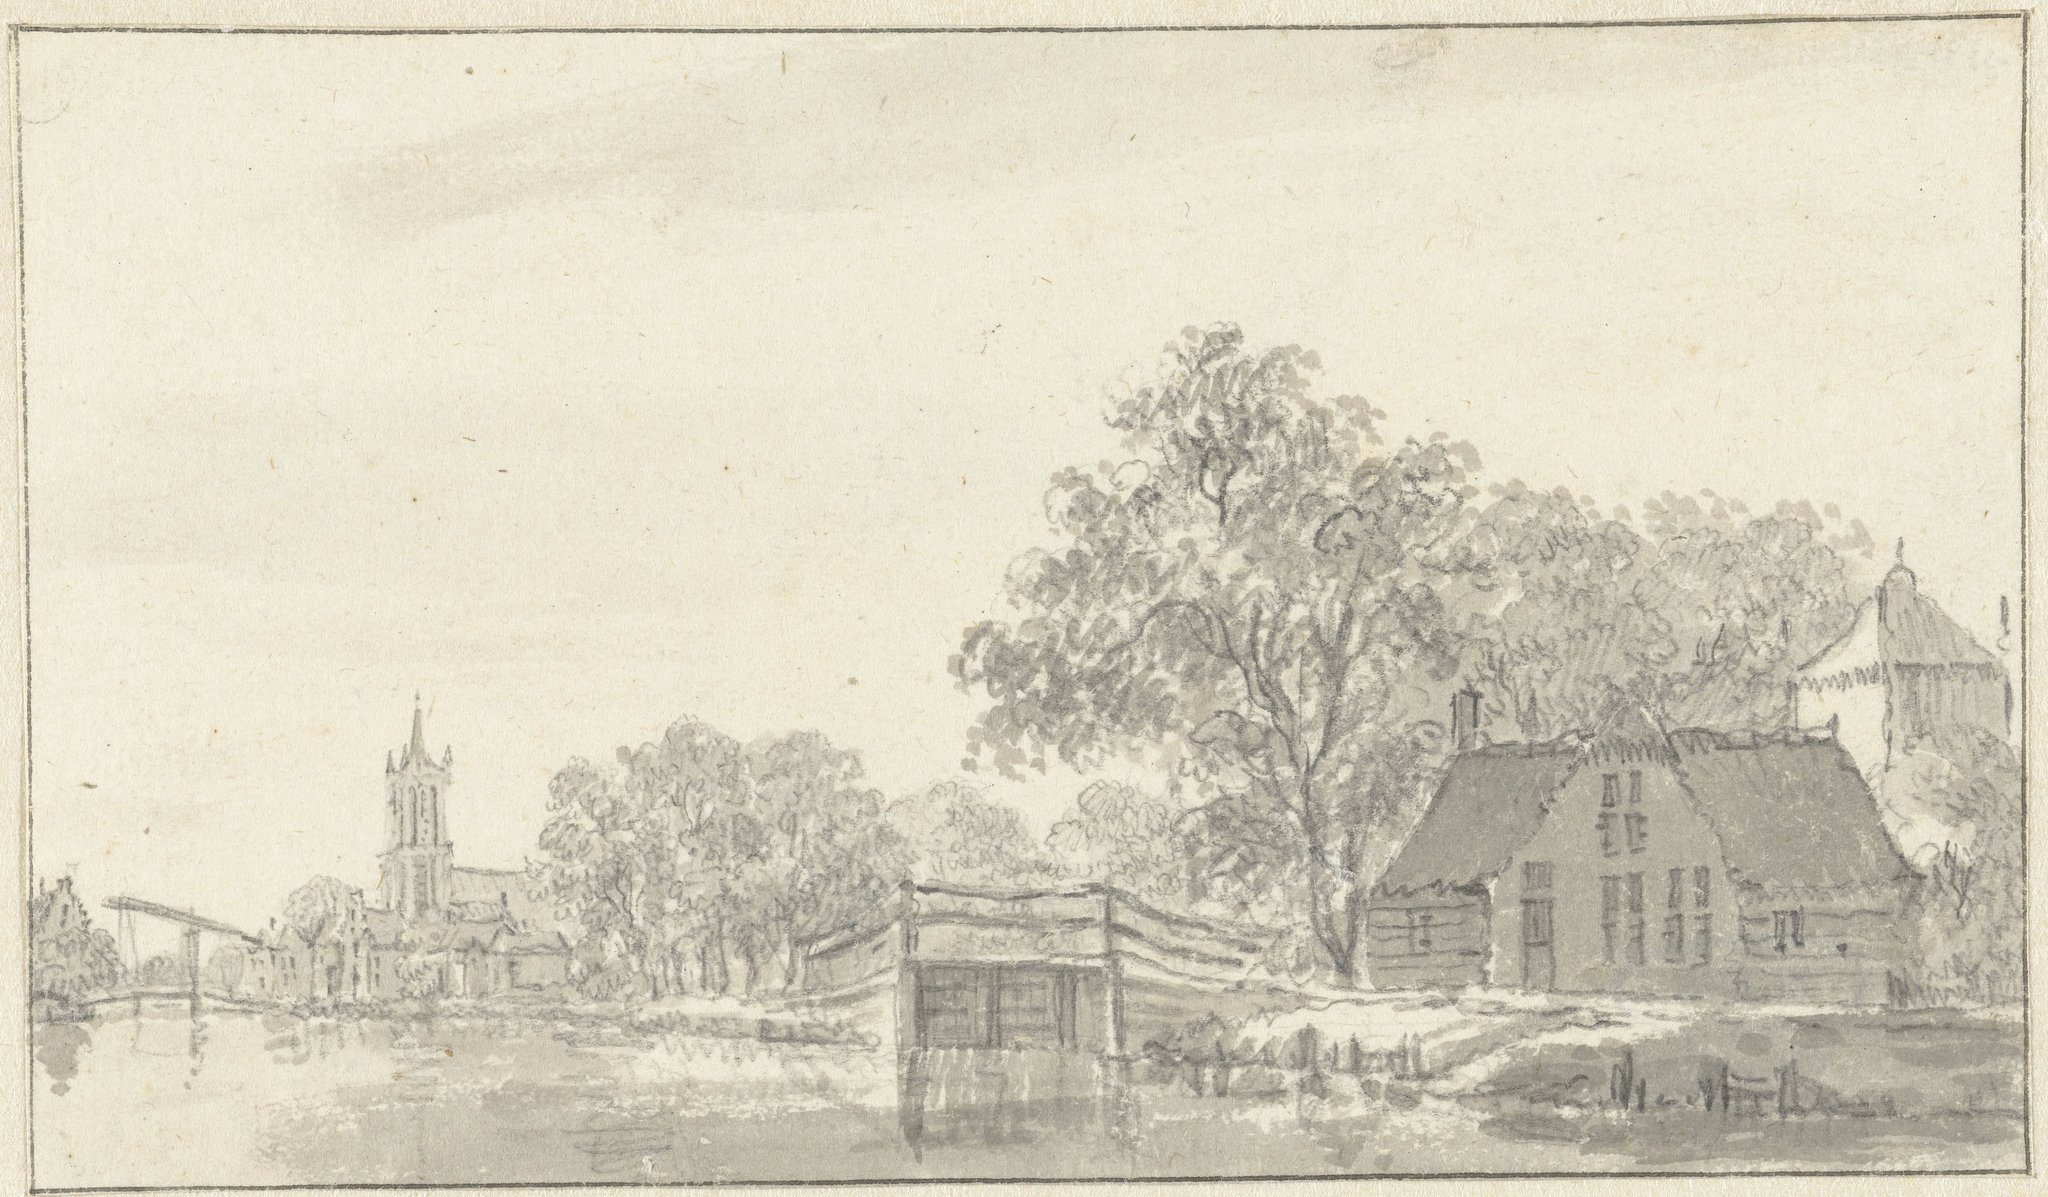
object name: drawing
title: Dorpsgezicht met rivier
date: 1737-1779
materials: paper, pencil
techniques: brush